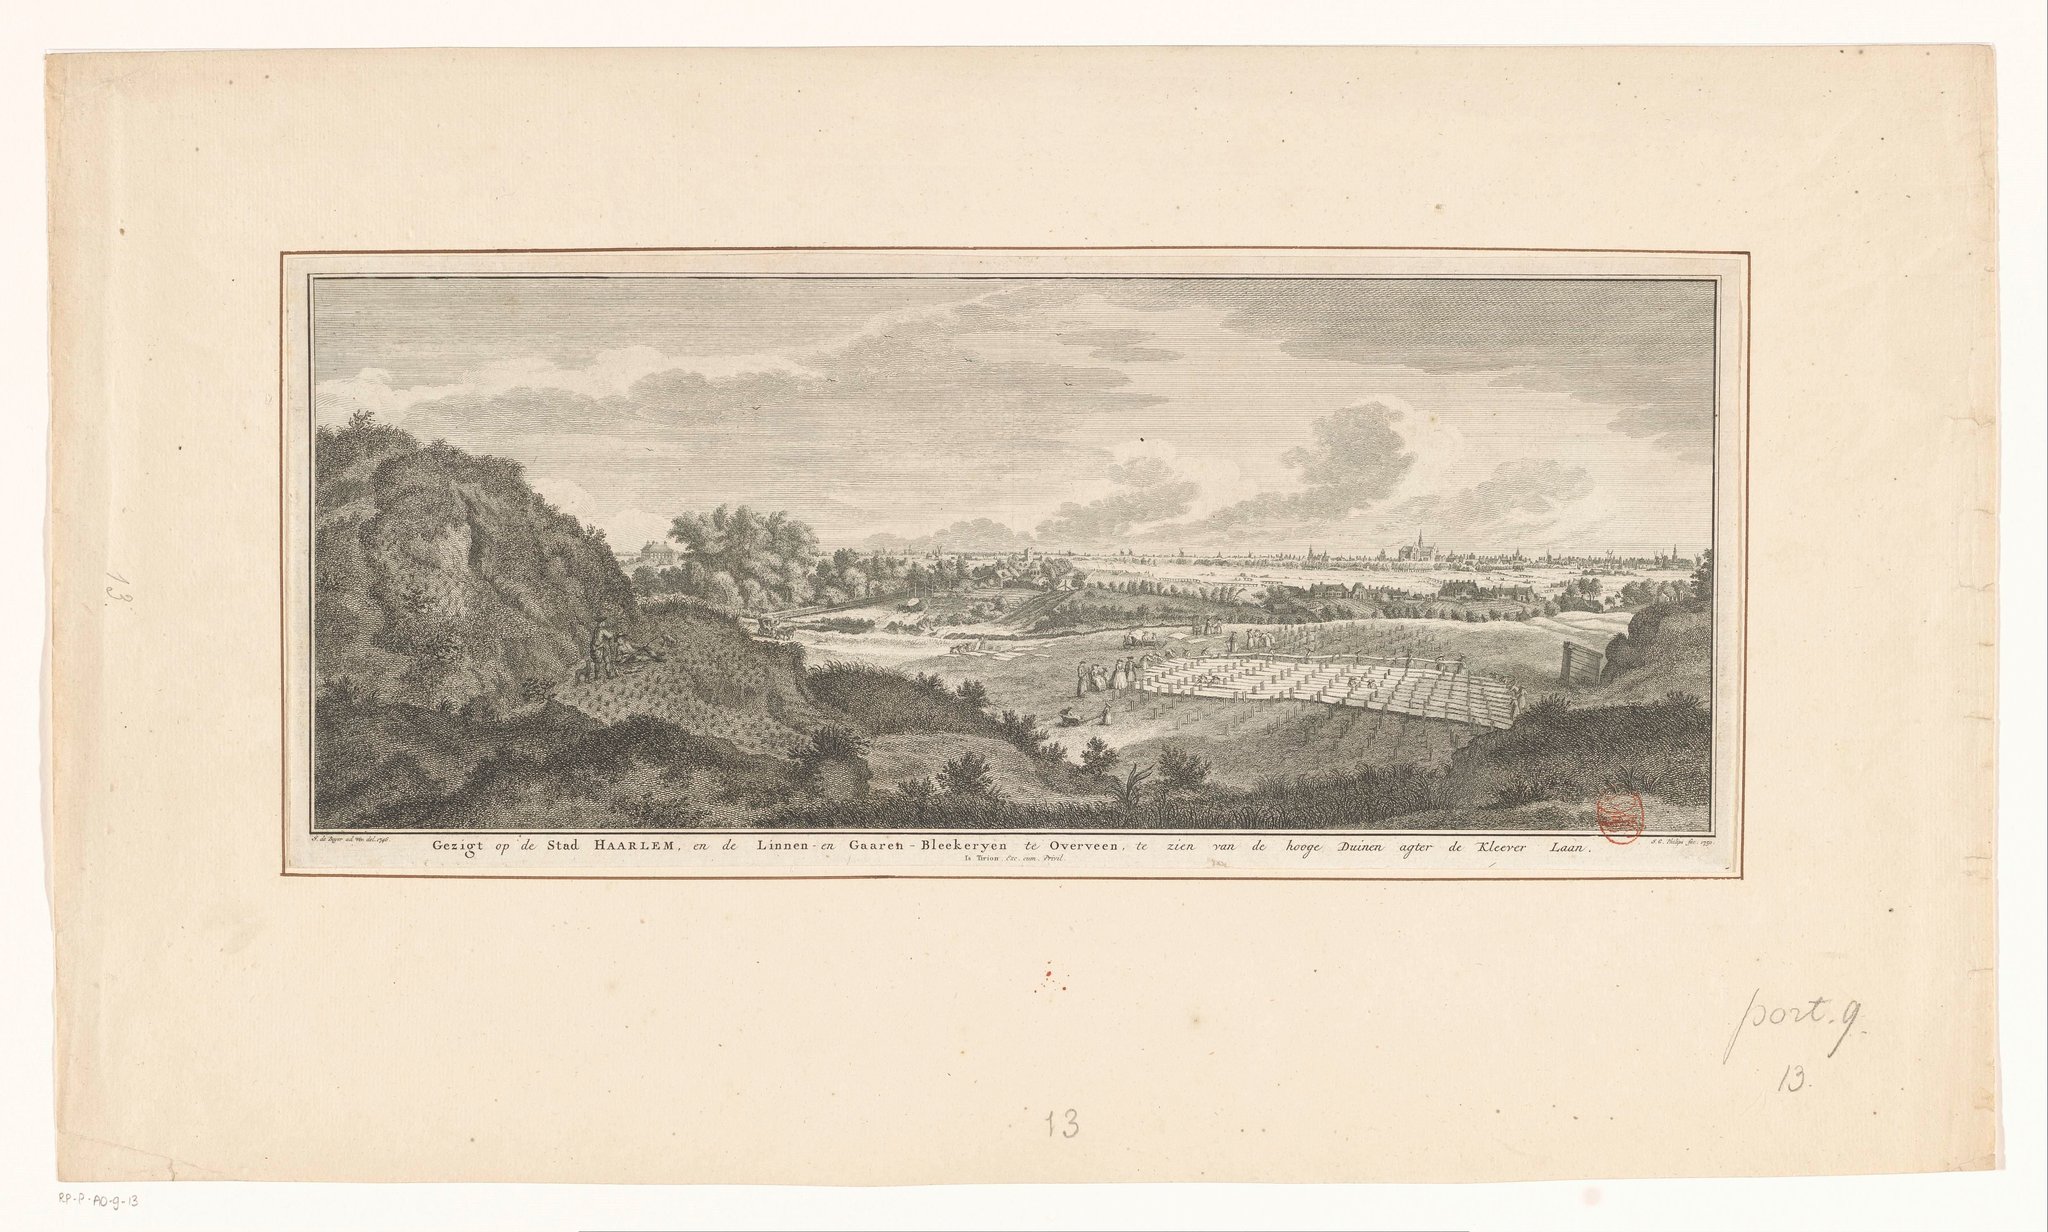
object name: print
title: Gezicht op Haarlem en Overveen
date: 1750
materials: paper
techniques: etching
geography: amsterdam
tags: prospect of village, silhouette of village, dunes (sea not visible); in the dunes, agriculture, prospect of city, town panorama, silhouette of city, haarlem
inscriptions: collector's mark: Lugt 195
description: Gezicht op Haarlem en Overveen, gezien vanuit de duinen. Rechts op de voorgrond zijn mensen aan het werk op een weide, waarop linnen wordt gebleekt.